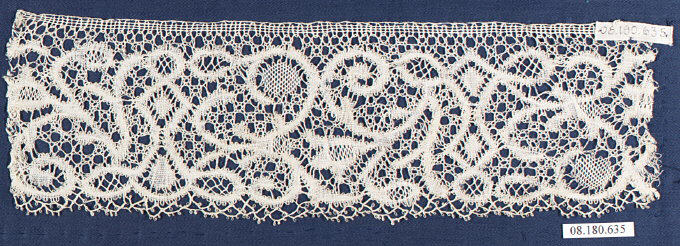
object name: piece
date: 1801-1900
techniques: lace